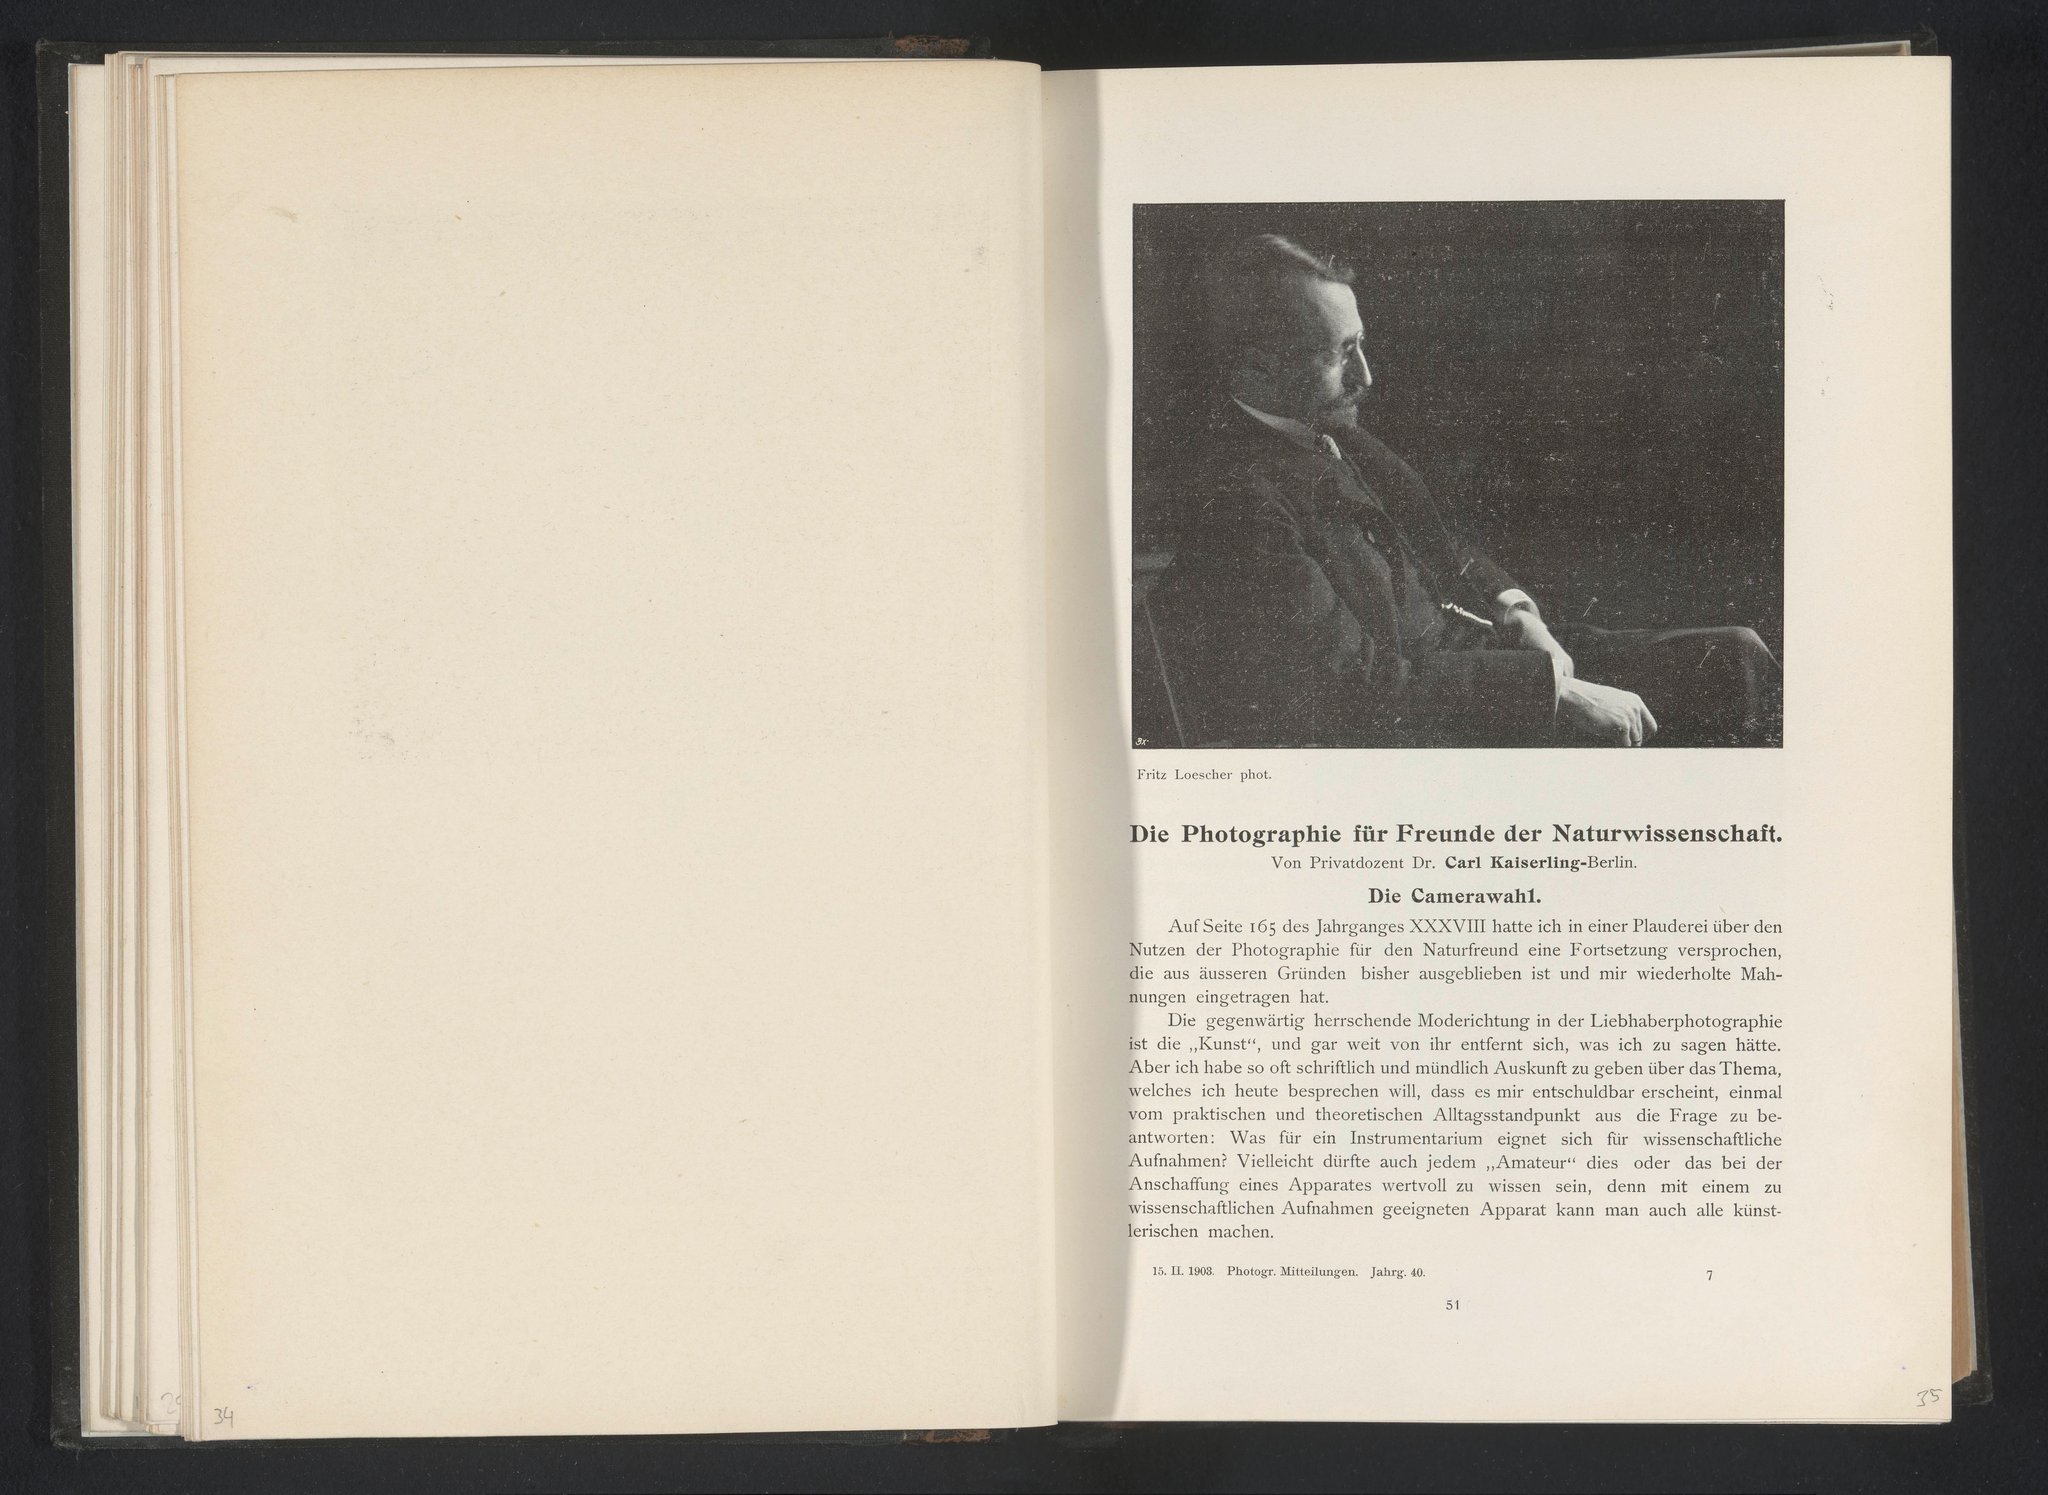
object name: photomechanical print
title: Portret van een onbekende man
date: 1898-1903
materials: paper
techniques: autotype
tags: historical persons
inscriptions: monogram: ‘BX’